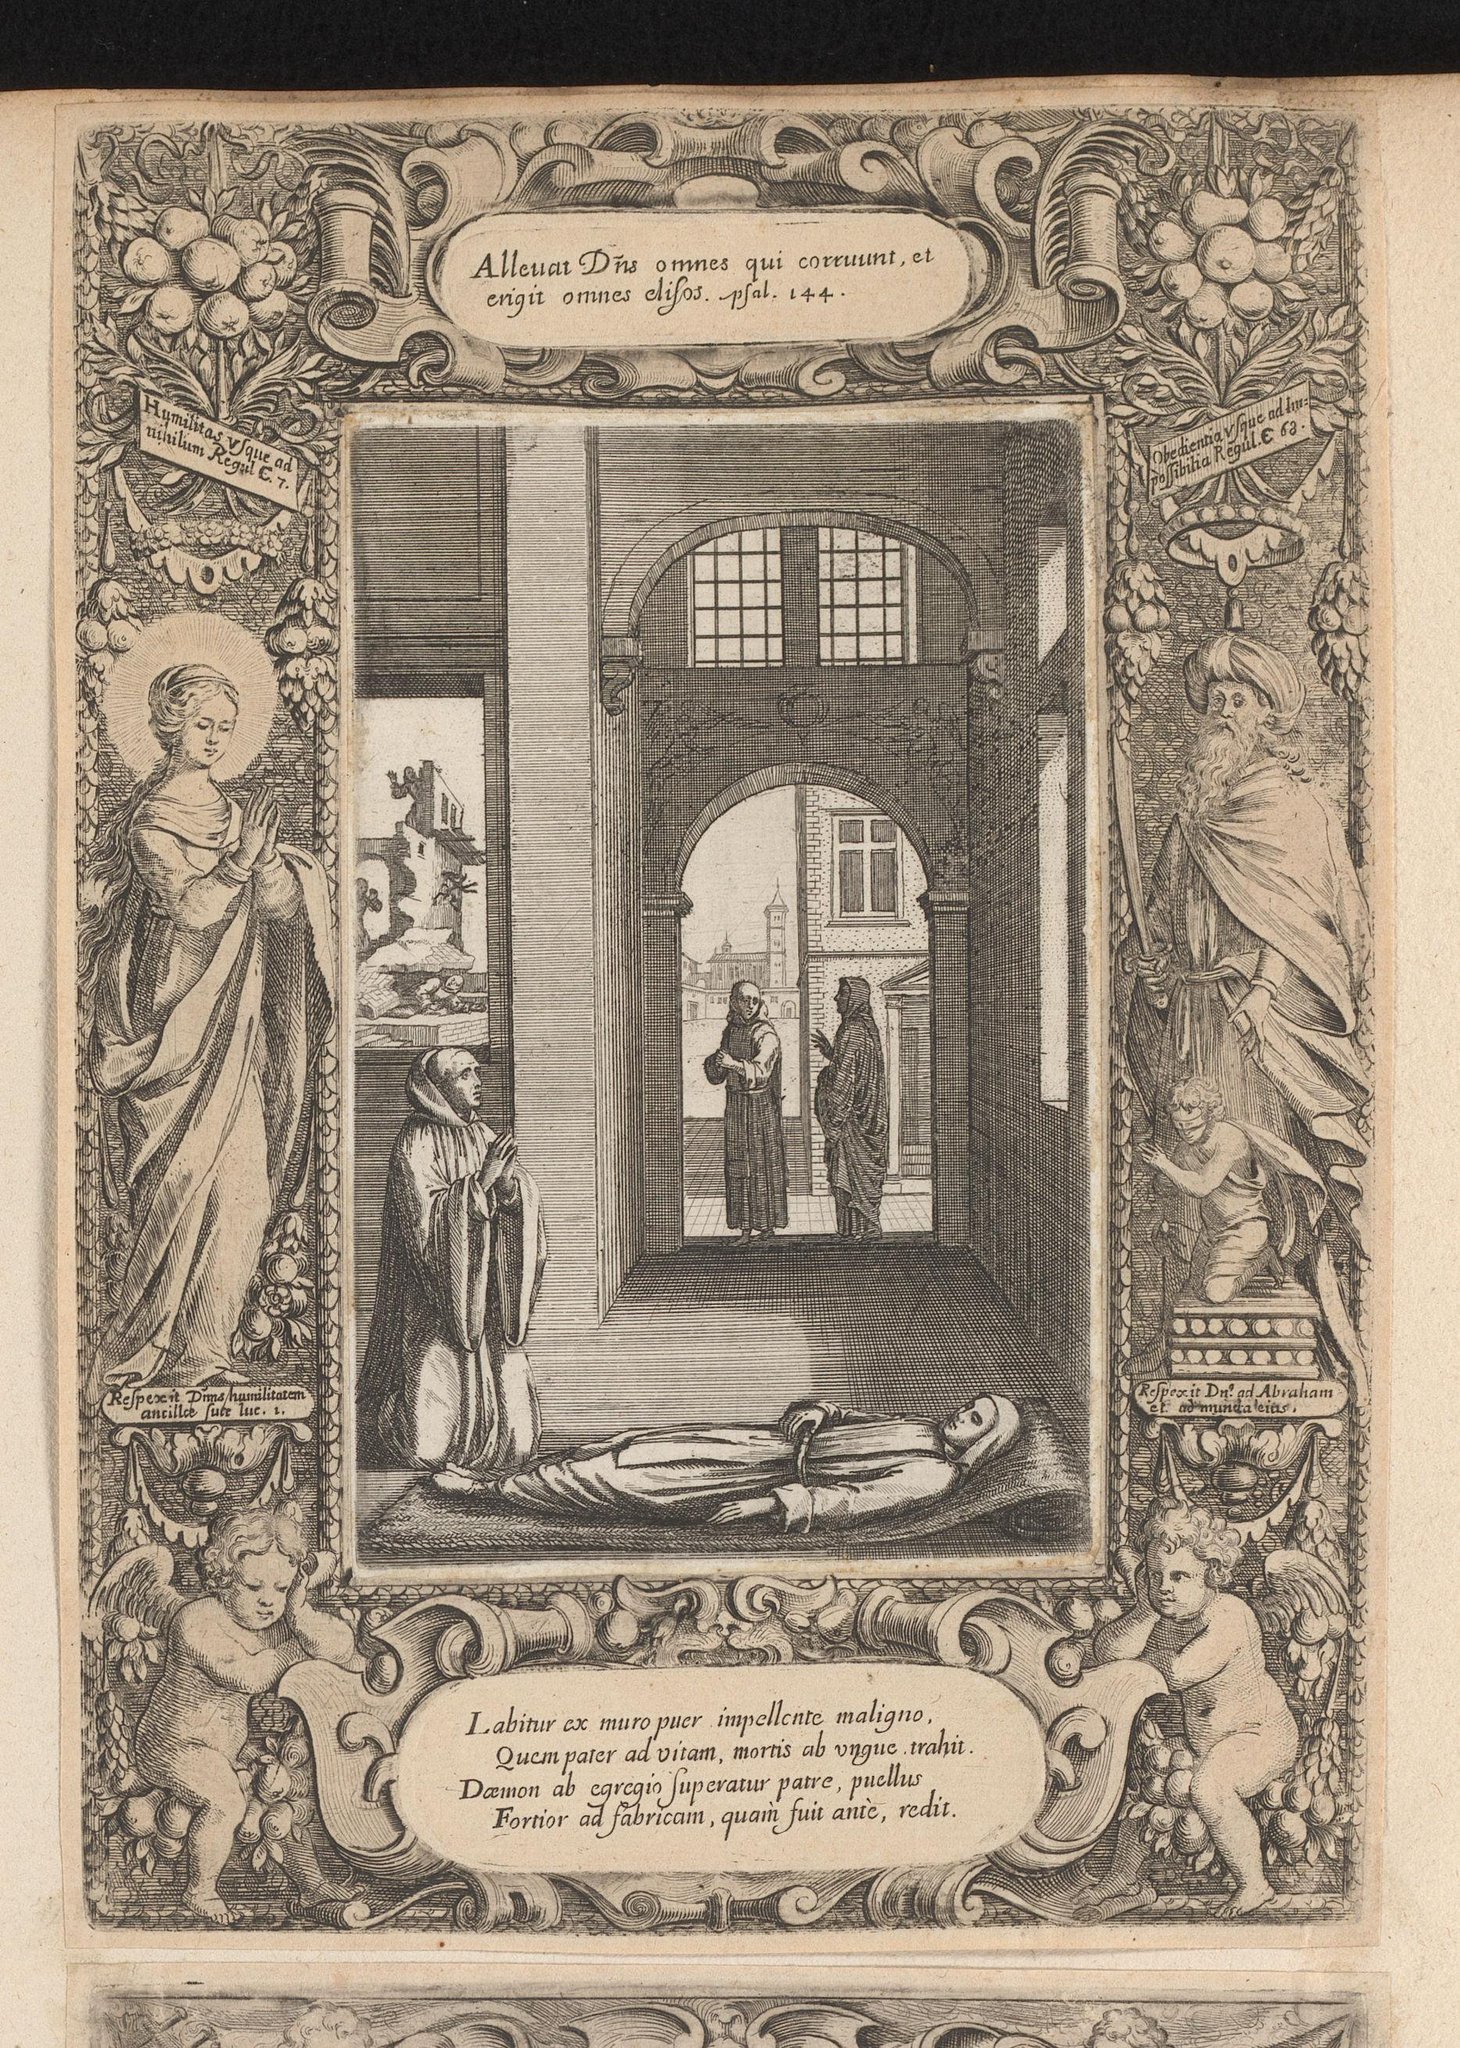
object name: album leaf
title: H. Benedictus bidt bij het lijk van een monnik en brengt hem tot leven, in een cartouche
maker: sébastien leclerc (i)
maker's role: print maker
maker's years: 1637-1714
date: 1658-1659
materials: paper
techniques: etching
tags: st. benedict restores a monk to life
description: Maakt deel uit van een serie bestaande uit 33 prenten met voorstellingen uit het leven van de Heilige Benedictus van Nursia in ornamentele cartouches, uitgegeven in 1658-1659. De prenten zijn gedrukt van drie afzonderlijke platen bestaande uit de voorstelling, de cartouche en de tekst.